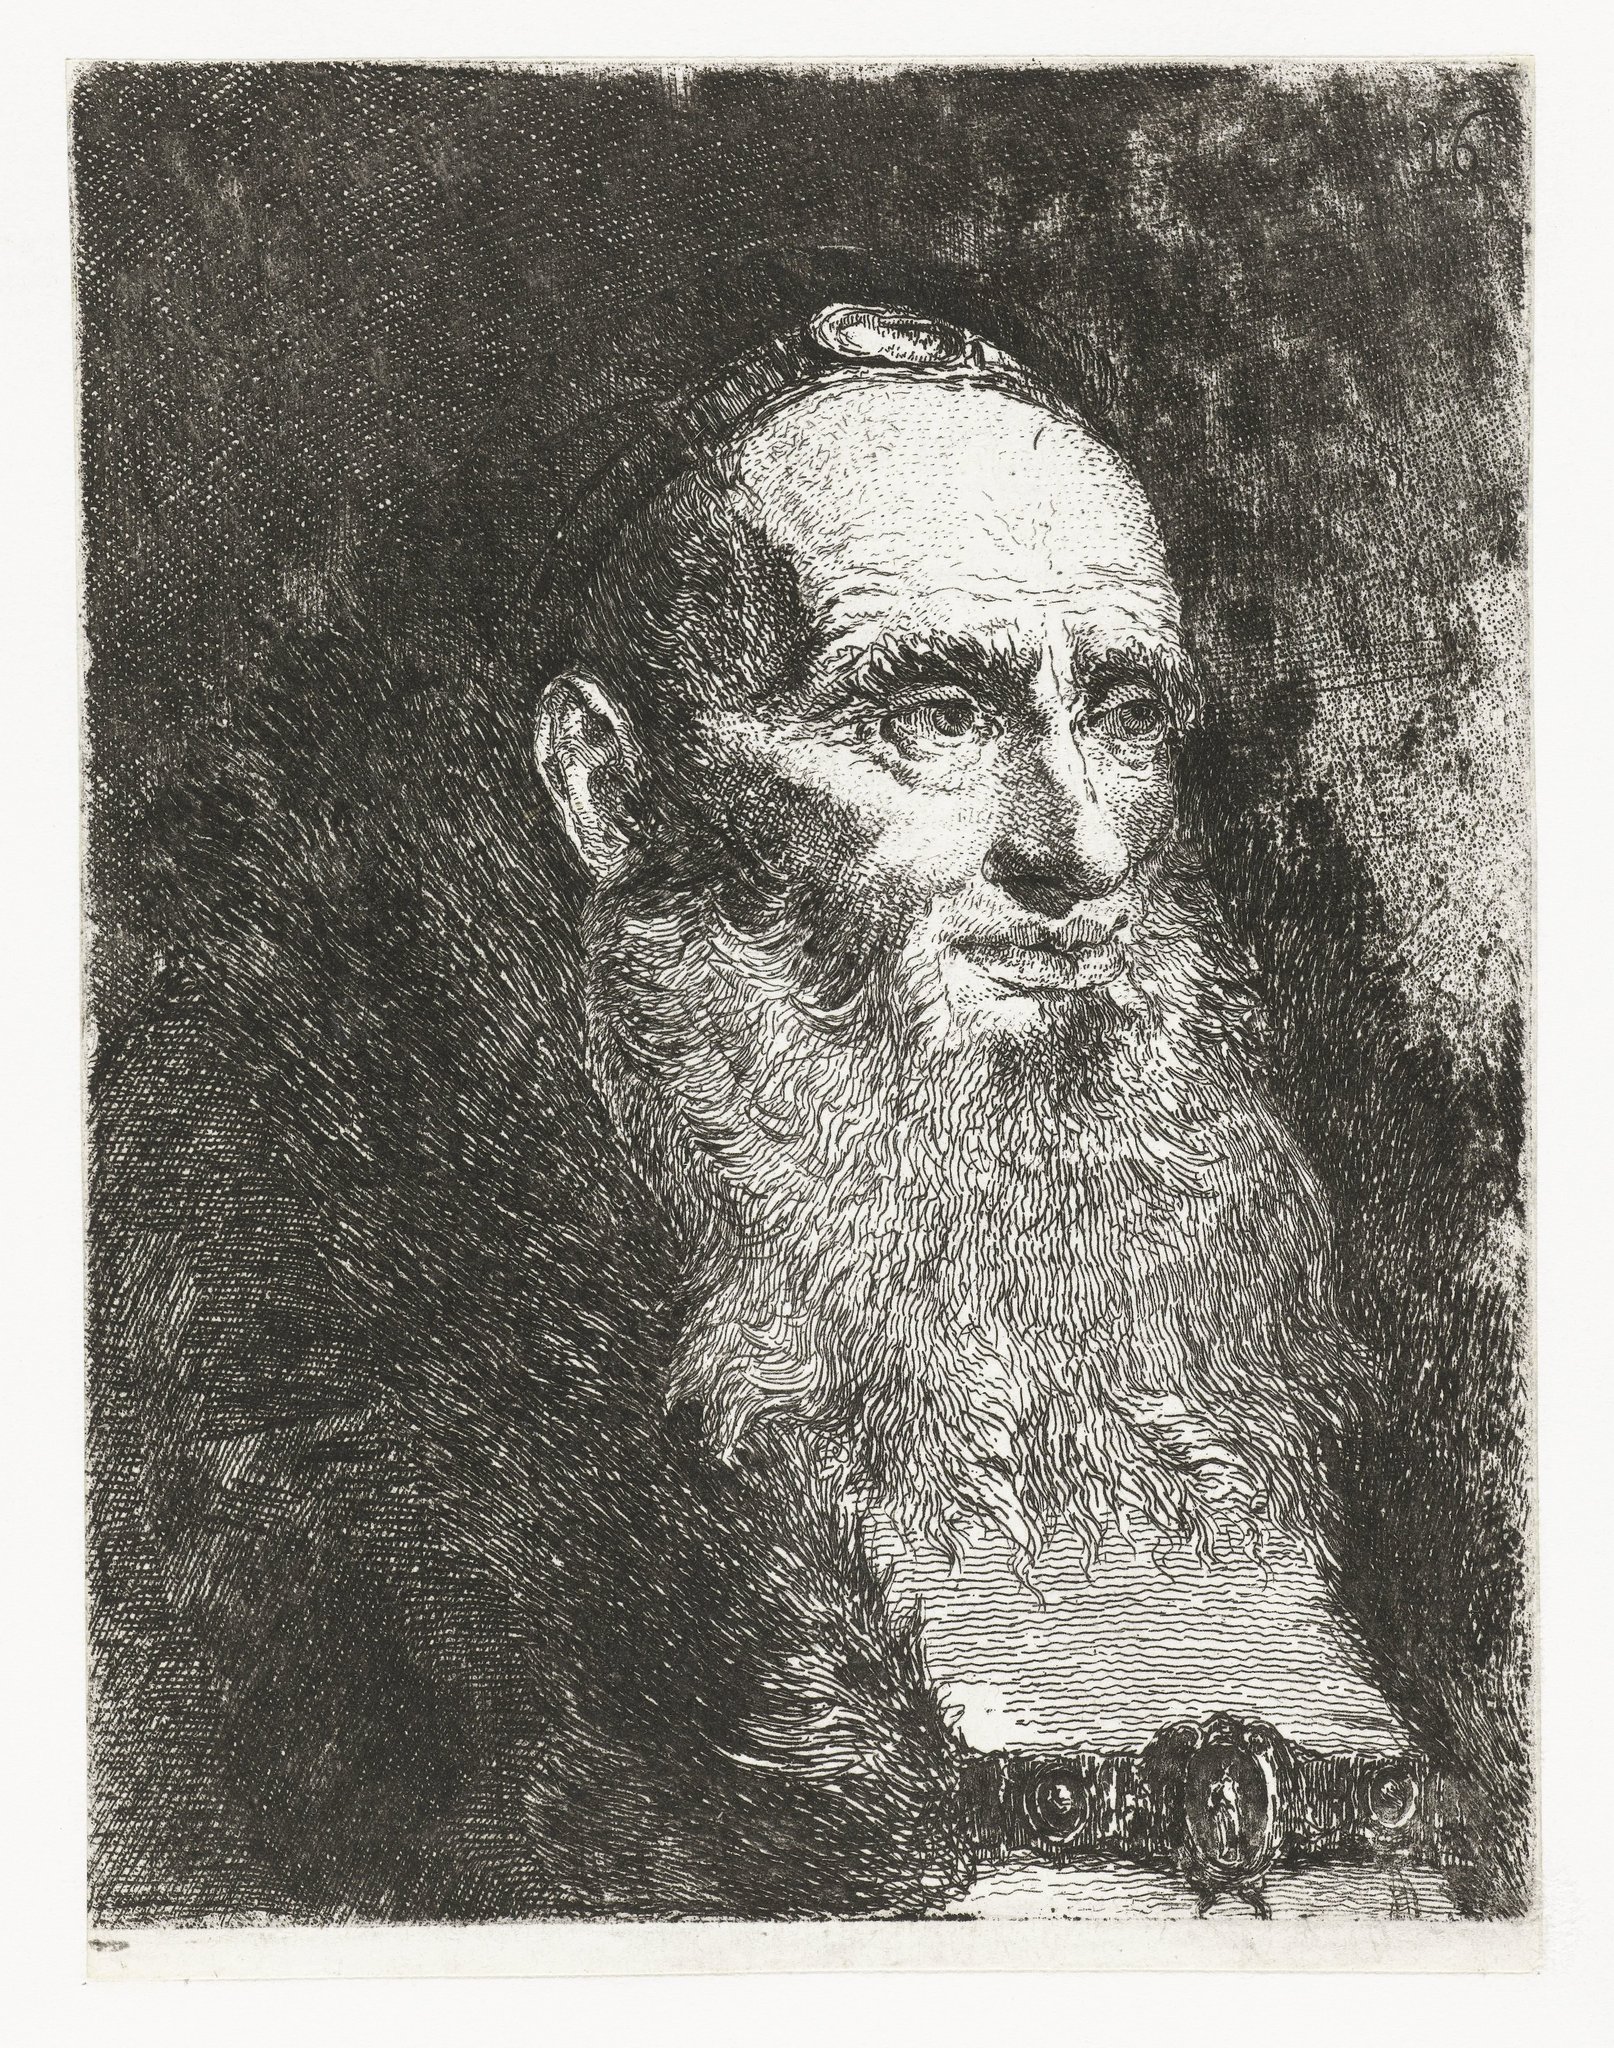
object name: print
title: Raccolta di Teste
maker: giovanni domenico tiepolo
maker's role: draughtsman, print maker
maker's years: 1727-1804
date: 1757-1758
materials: paper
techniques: etching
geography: venice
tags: old man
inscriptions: collector's mark: Lugt 2228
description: Prent uit serie Verzameling hoofden (Raccolta di teste). Giovanni Domenico Tiepolo vervaardigde in de winter van 1757-1758 en in de periode van 1771-1774 deze hoofden naar schilderijen en tekeningen van Giovanni Battista Tiepolo. De eerste uitgave verscheen in 1774 in twee delen met elk dertig prenten. Deze prent werd opgenomen in deel 1.